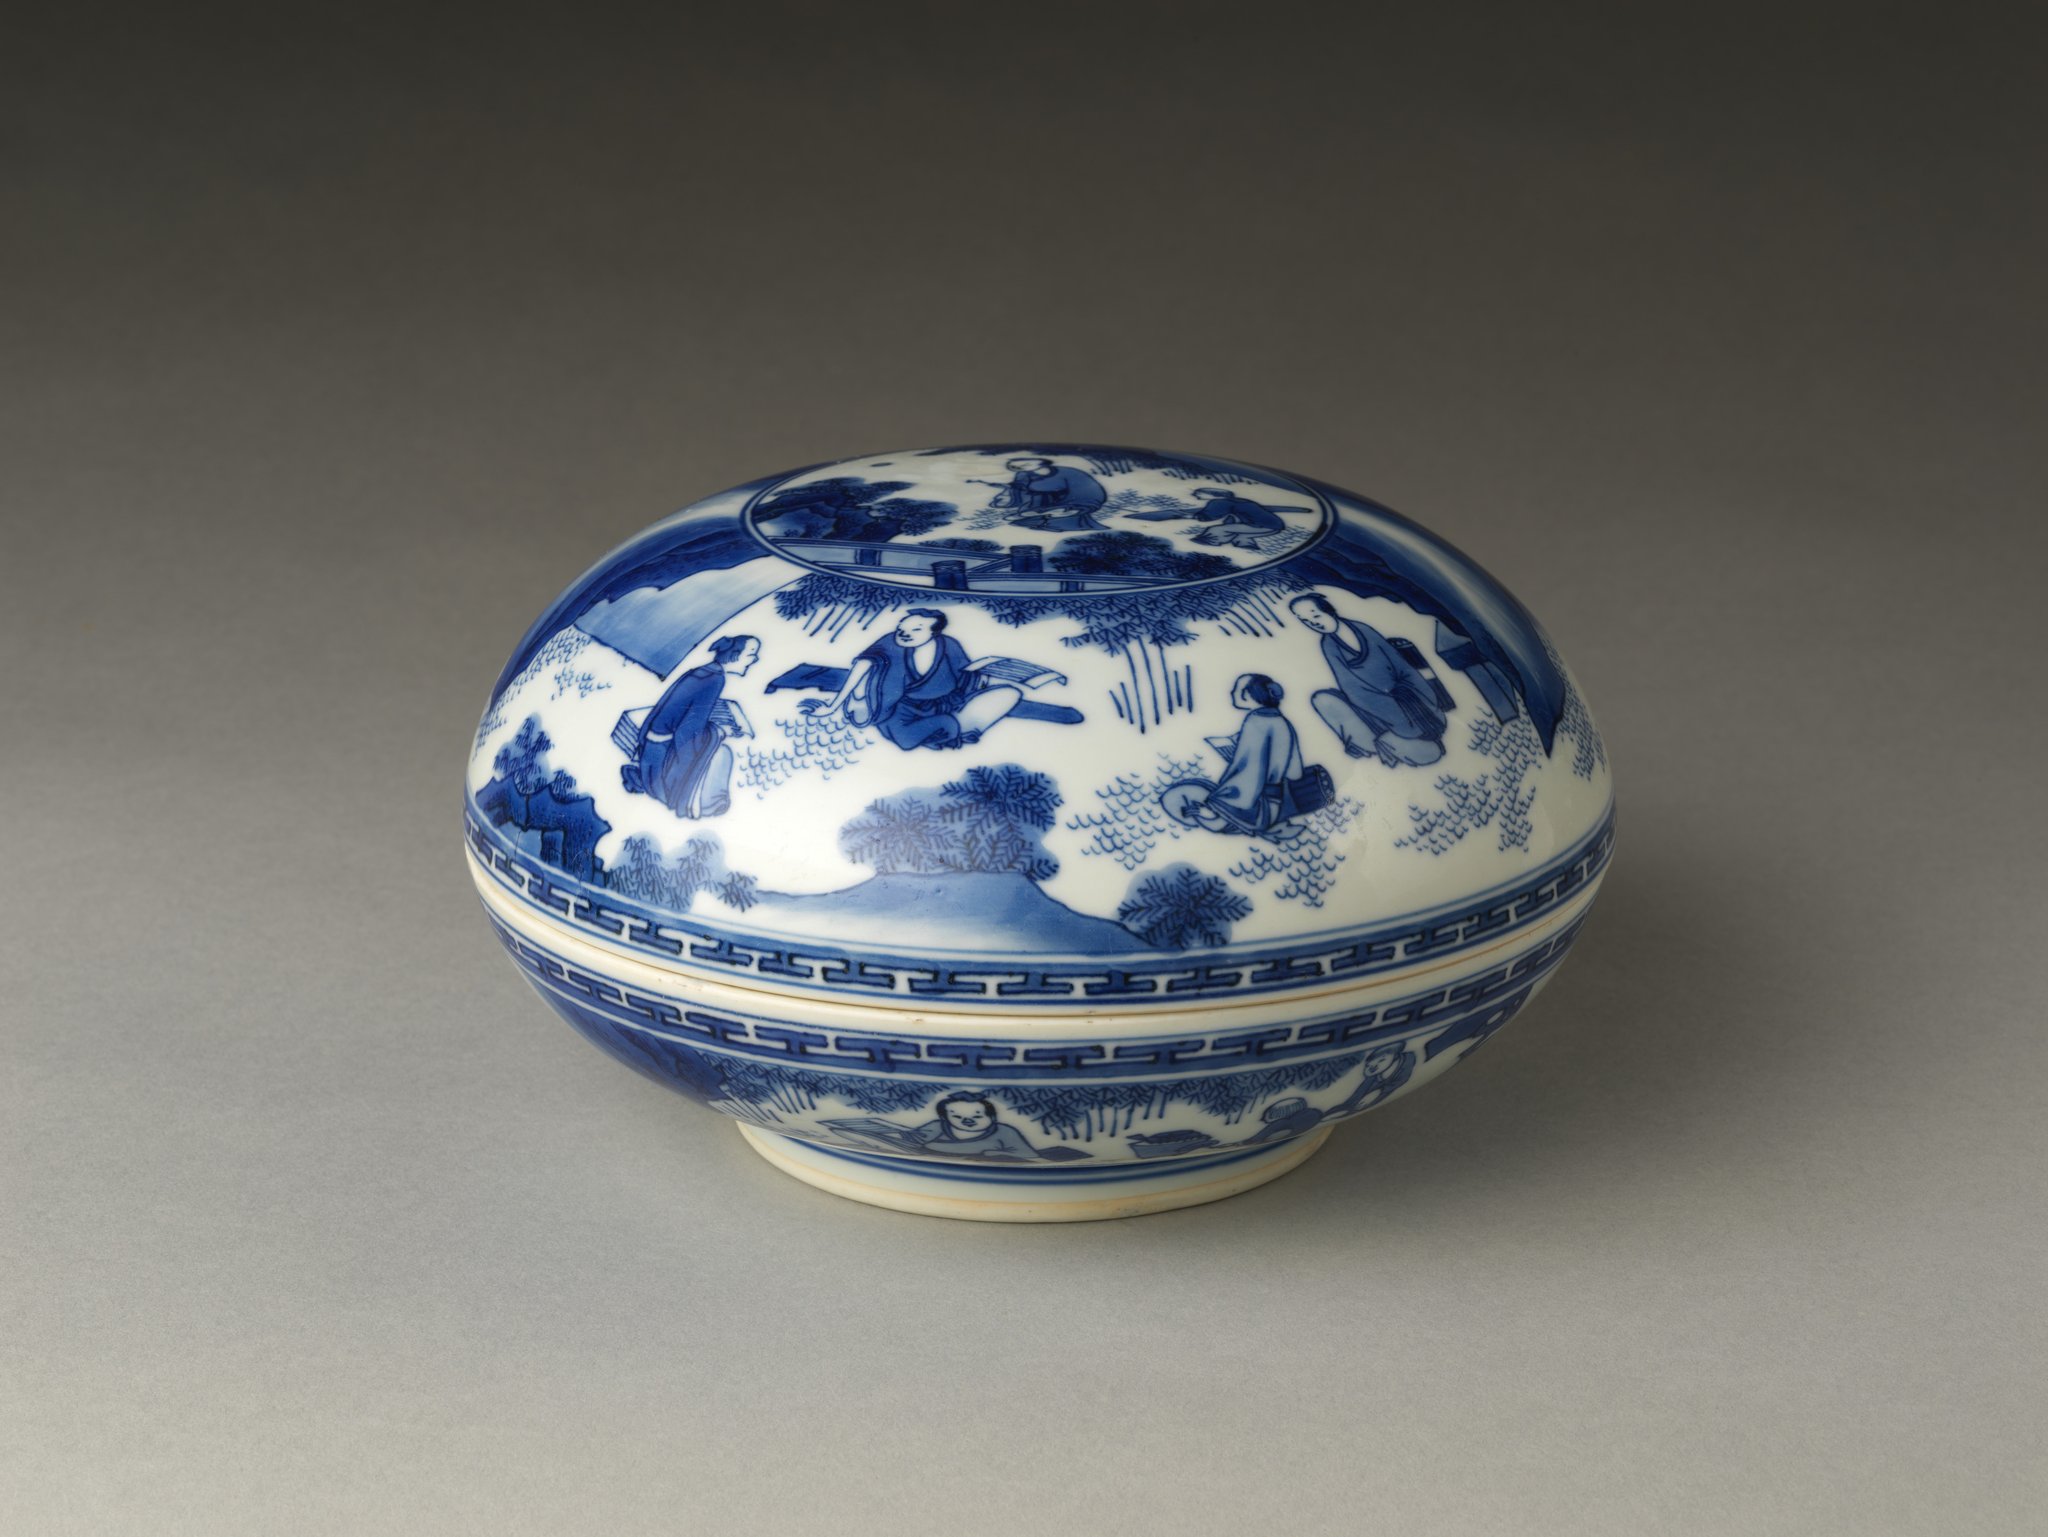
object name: covered box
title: Covered box decorated with the Seven Sages of the Bamboo Grove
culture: chinese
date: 1640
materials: cobalt, porcelain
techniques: painting, underglaze